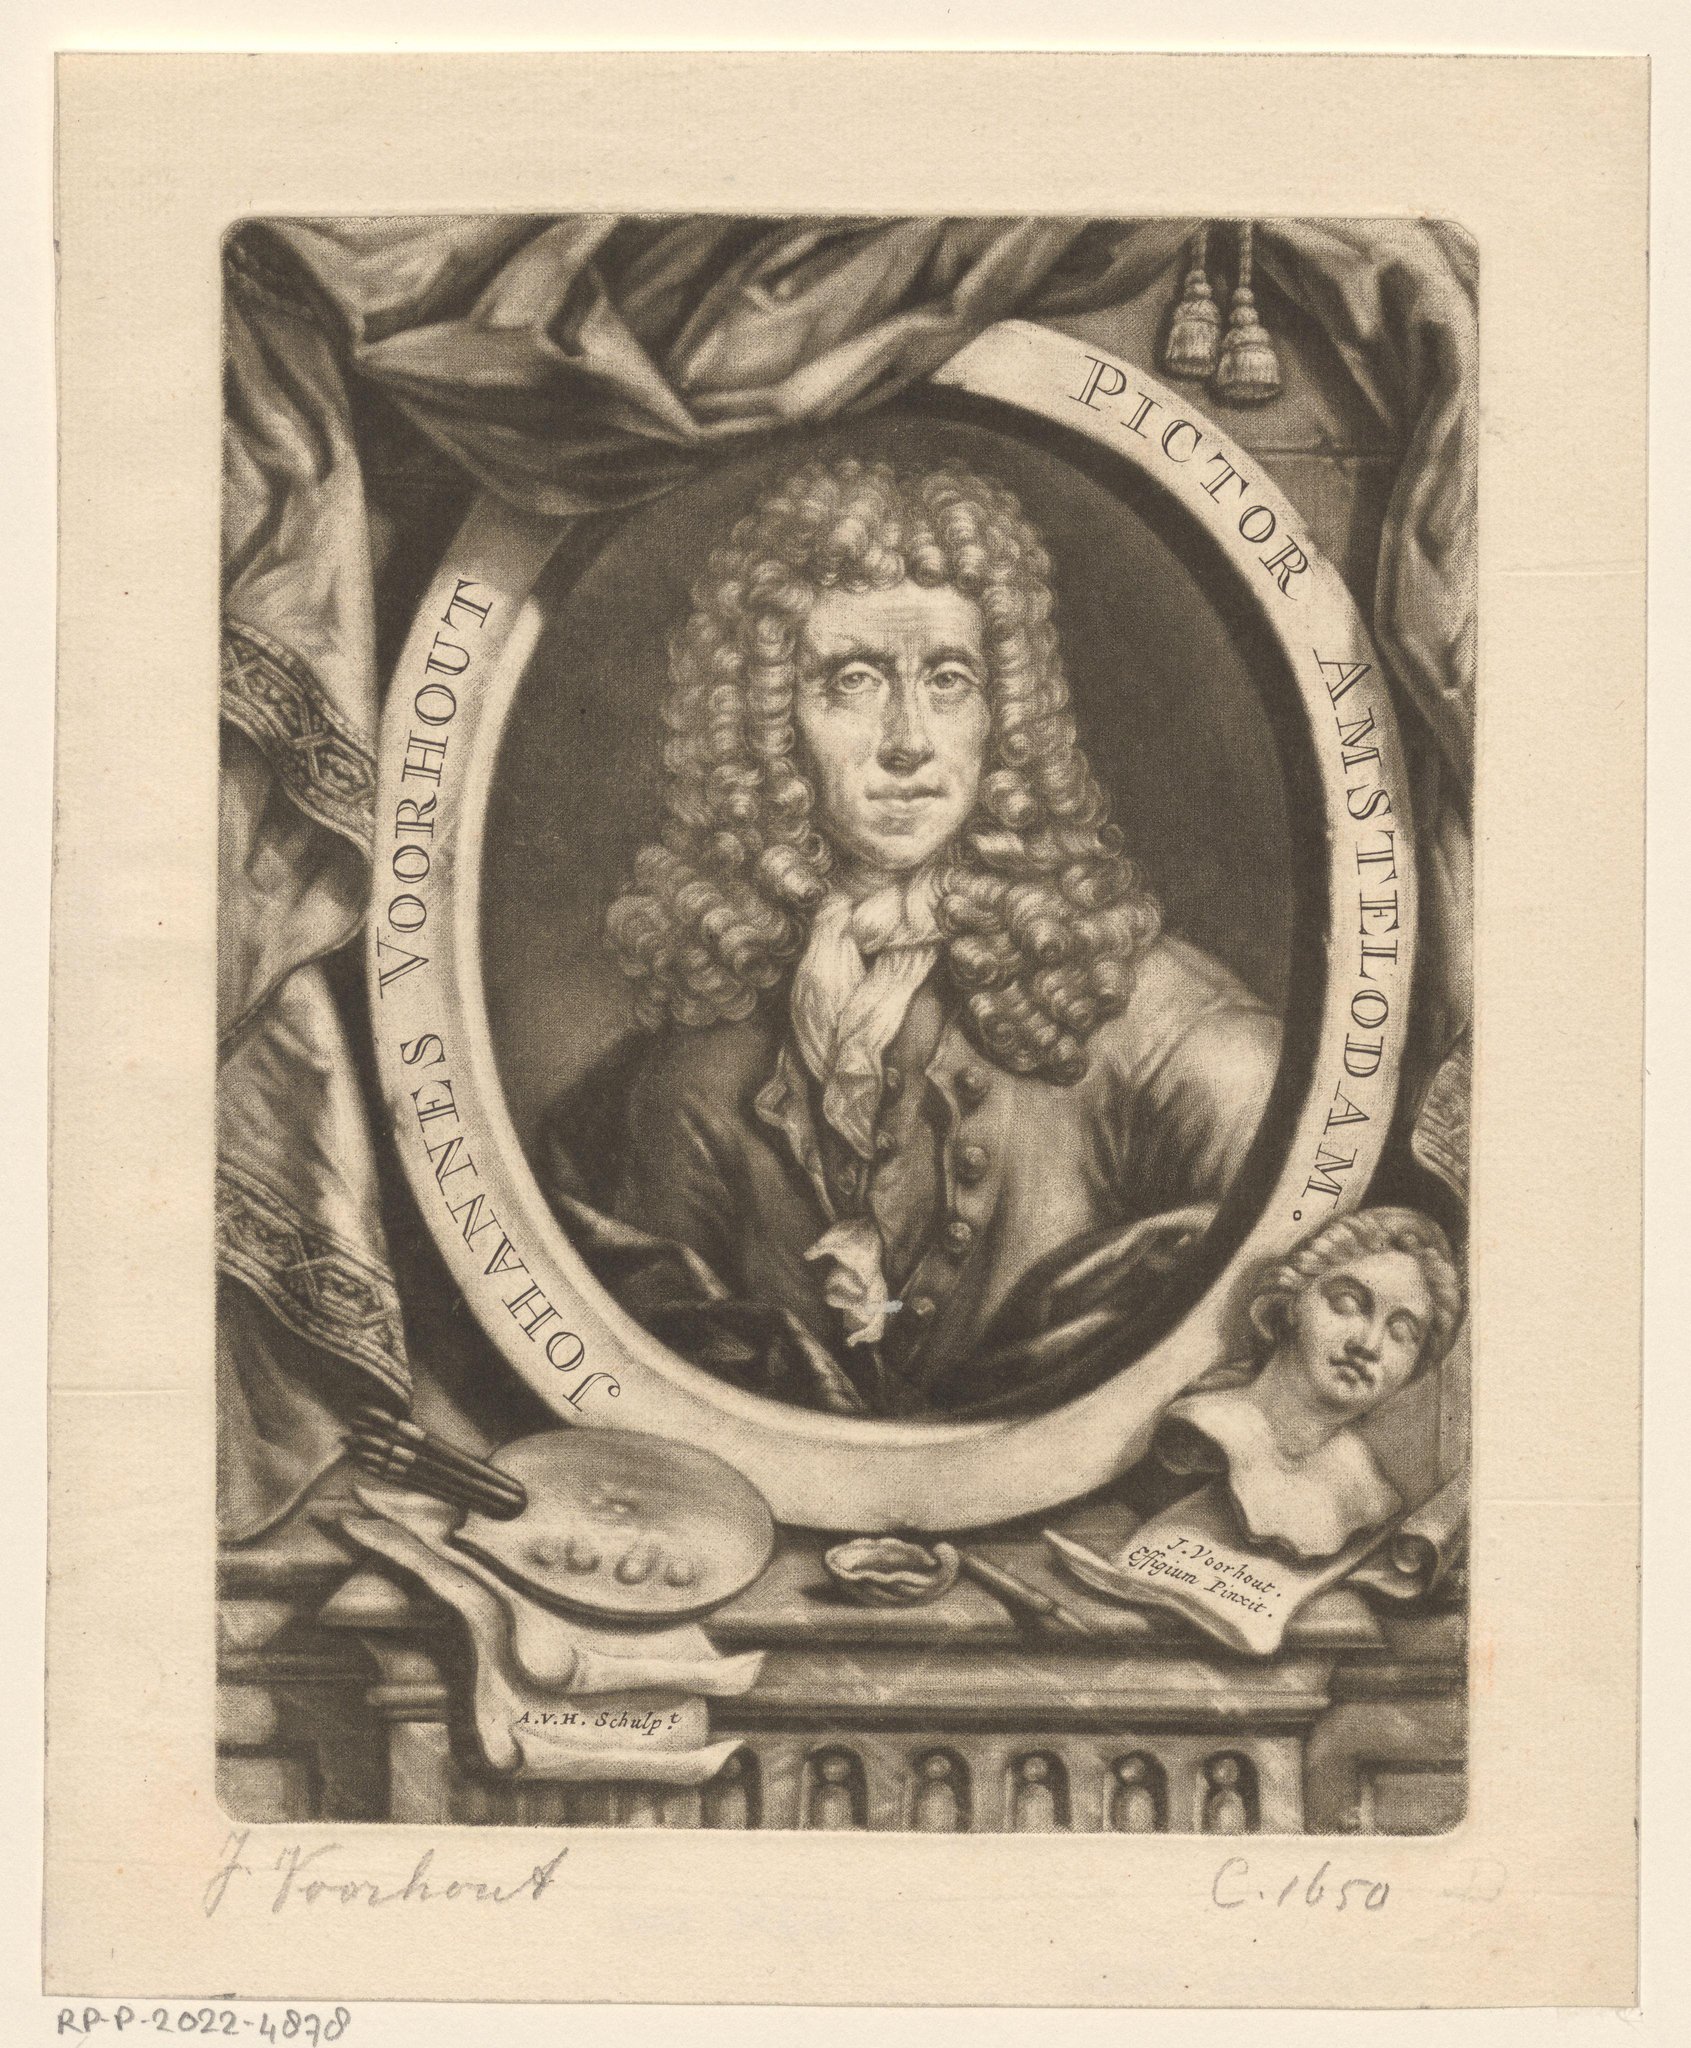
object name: print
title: Portret van Johannes Voorhout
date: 1683-1732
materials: paper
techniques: engraving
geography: amsterdam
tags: painter, draughtsman, johannes voorhout (i), historical persons, portrait, self-portrait of painter, portrait, self-portrait of draughtsman